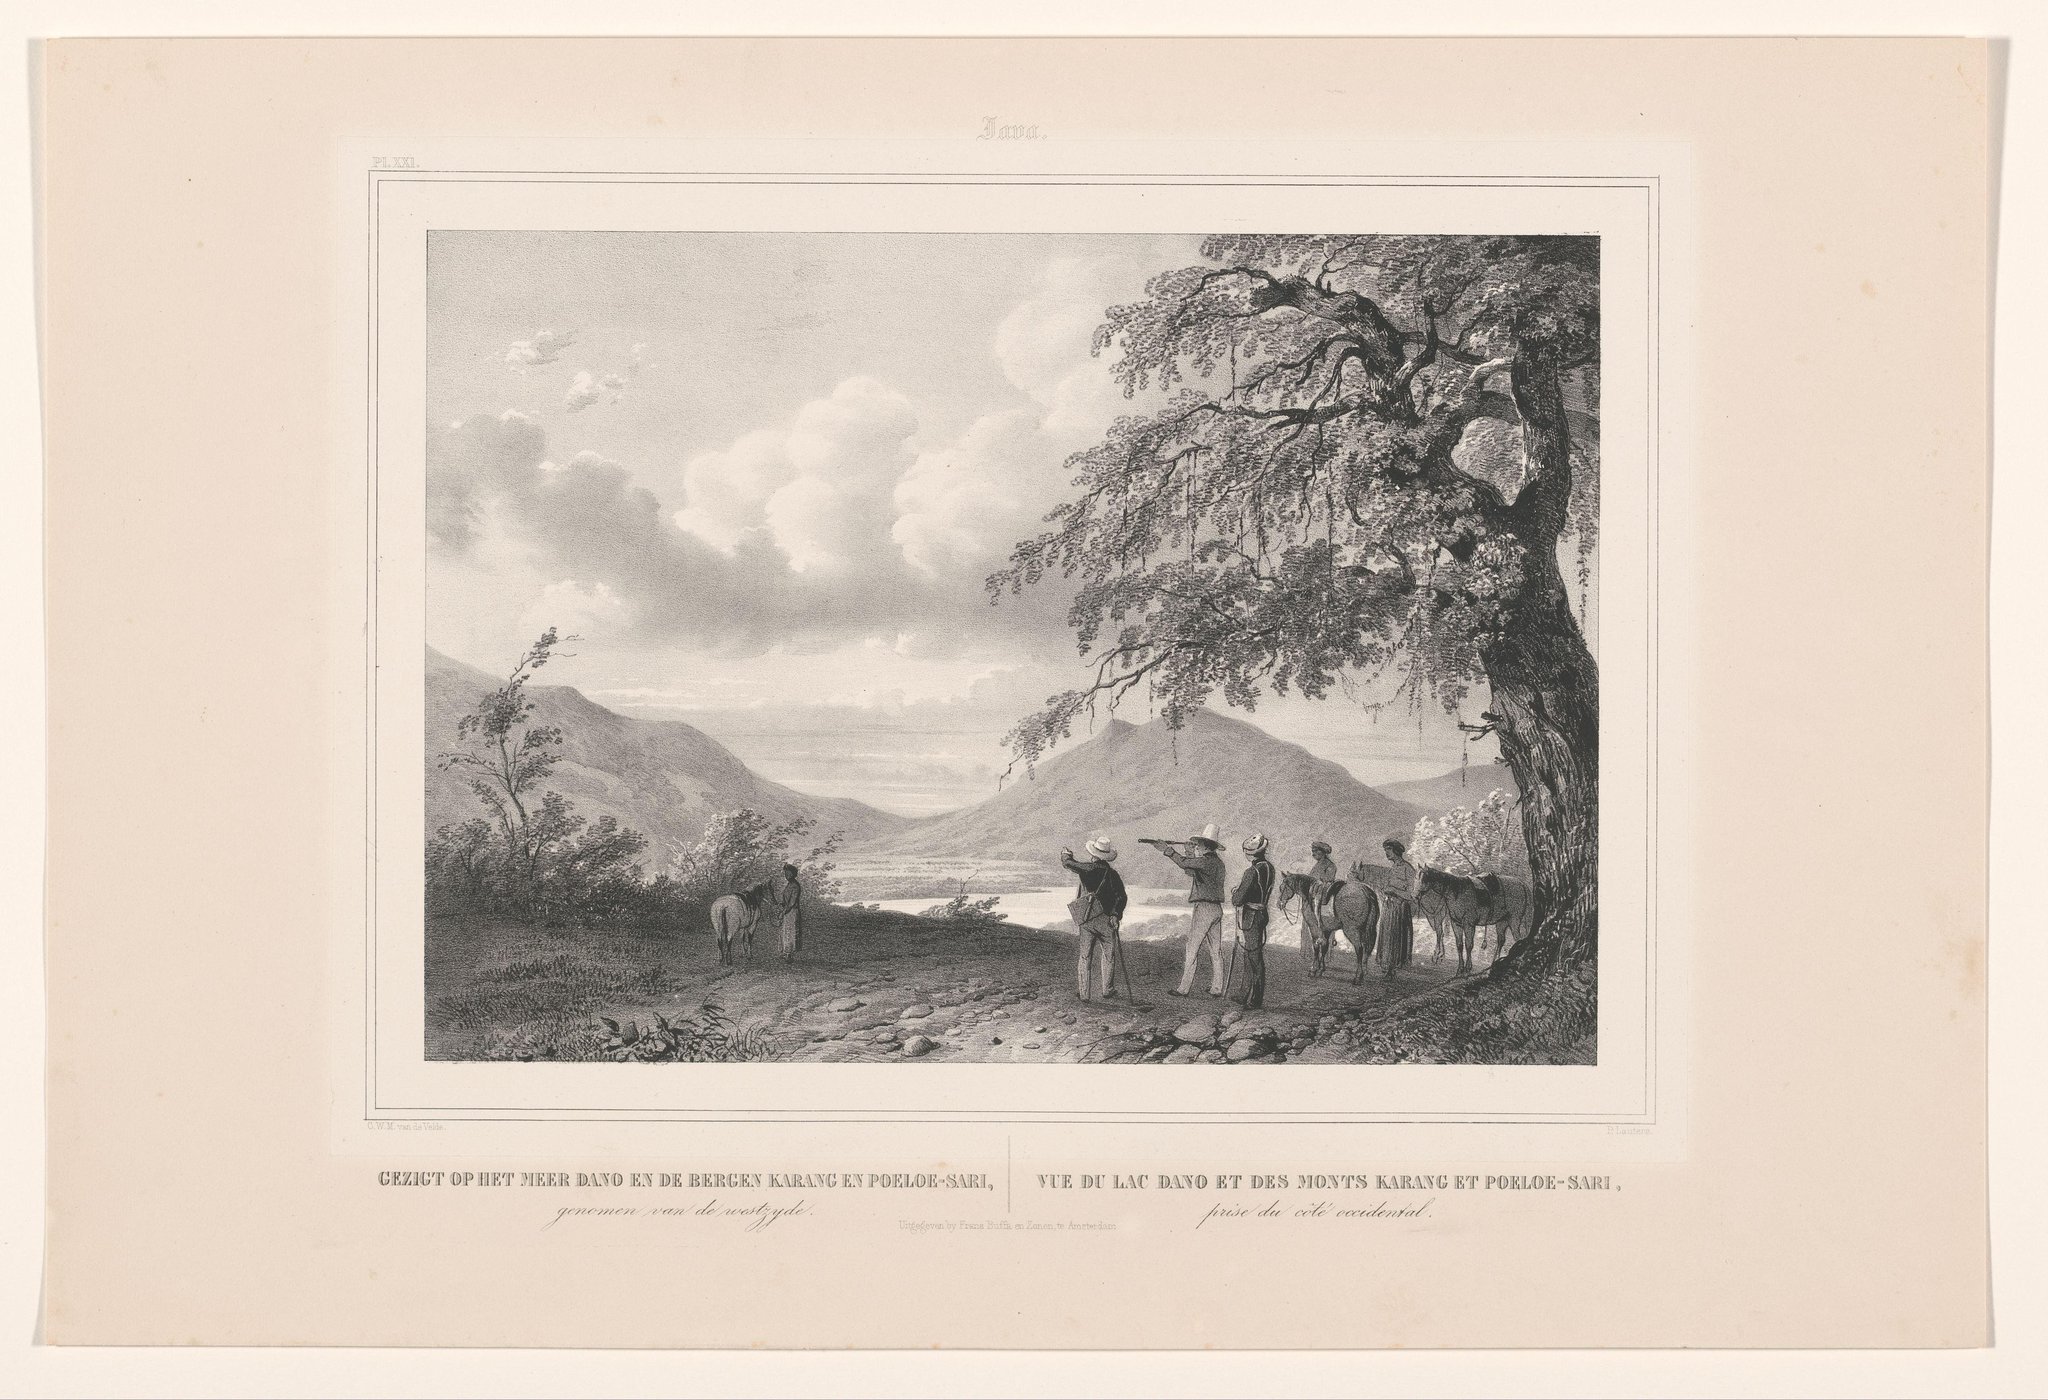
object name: print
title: Gezigt op het meer Dano en de bergen Karang en Poeloe-Sari, genomen van de waterzijde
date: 1843-1845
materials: paper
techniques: lithograph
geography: amsterdam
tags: volcano, binoculars, spy-glass, etc., java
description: Rechts staan enkele mannen en paarden. Een van hen kijkt door een verrekijker naar de vulkanen. Genummerd linksboven: Pl. XXI. De prent maakt deel uit van een omslag met zes bladen.